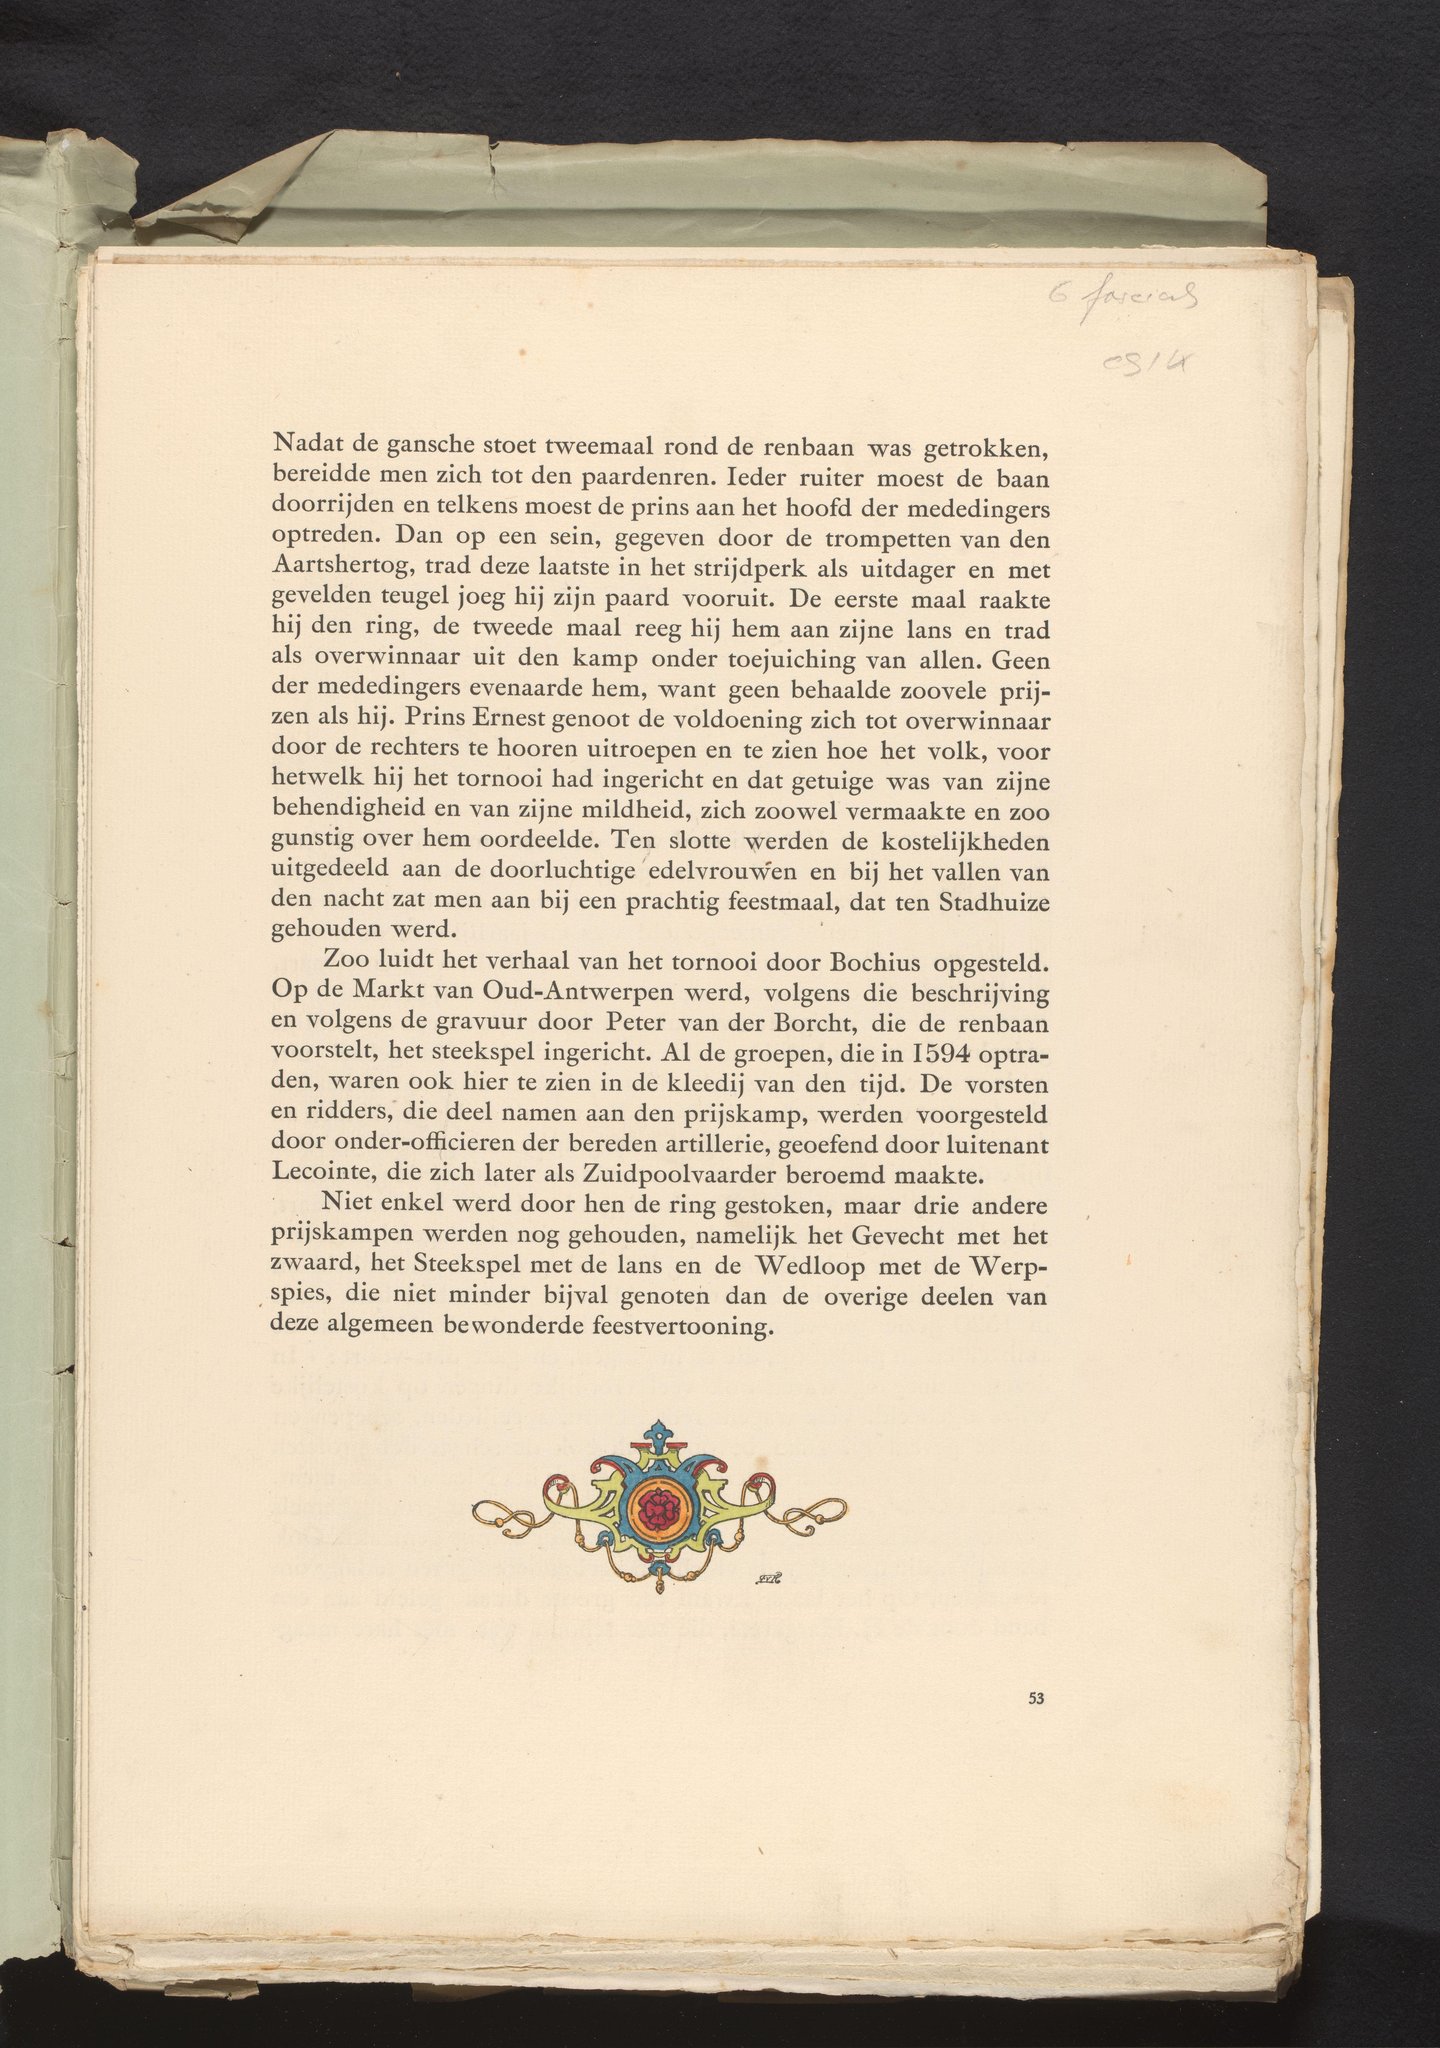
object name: book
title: De wijk Oud-Antwerpen in de wereldtentoonstelling van 1894 / in beeld gebracht door Frans van Kuyck; beschreven door Max Rooses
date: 1894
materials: paper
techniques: photograph, lithograph, etching, printing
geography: brussels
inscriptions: name: ‘H. Kuff[...]’, annotation: ‘6 fascials/ cs/k’